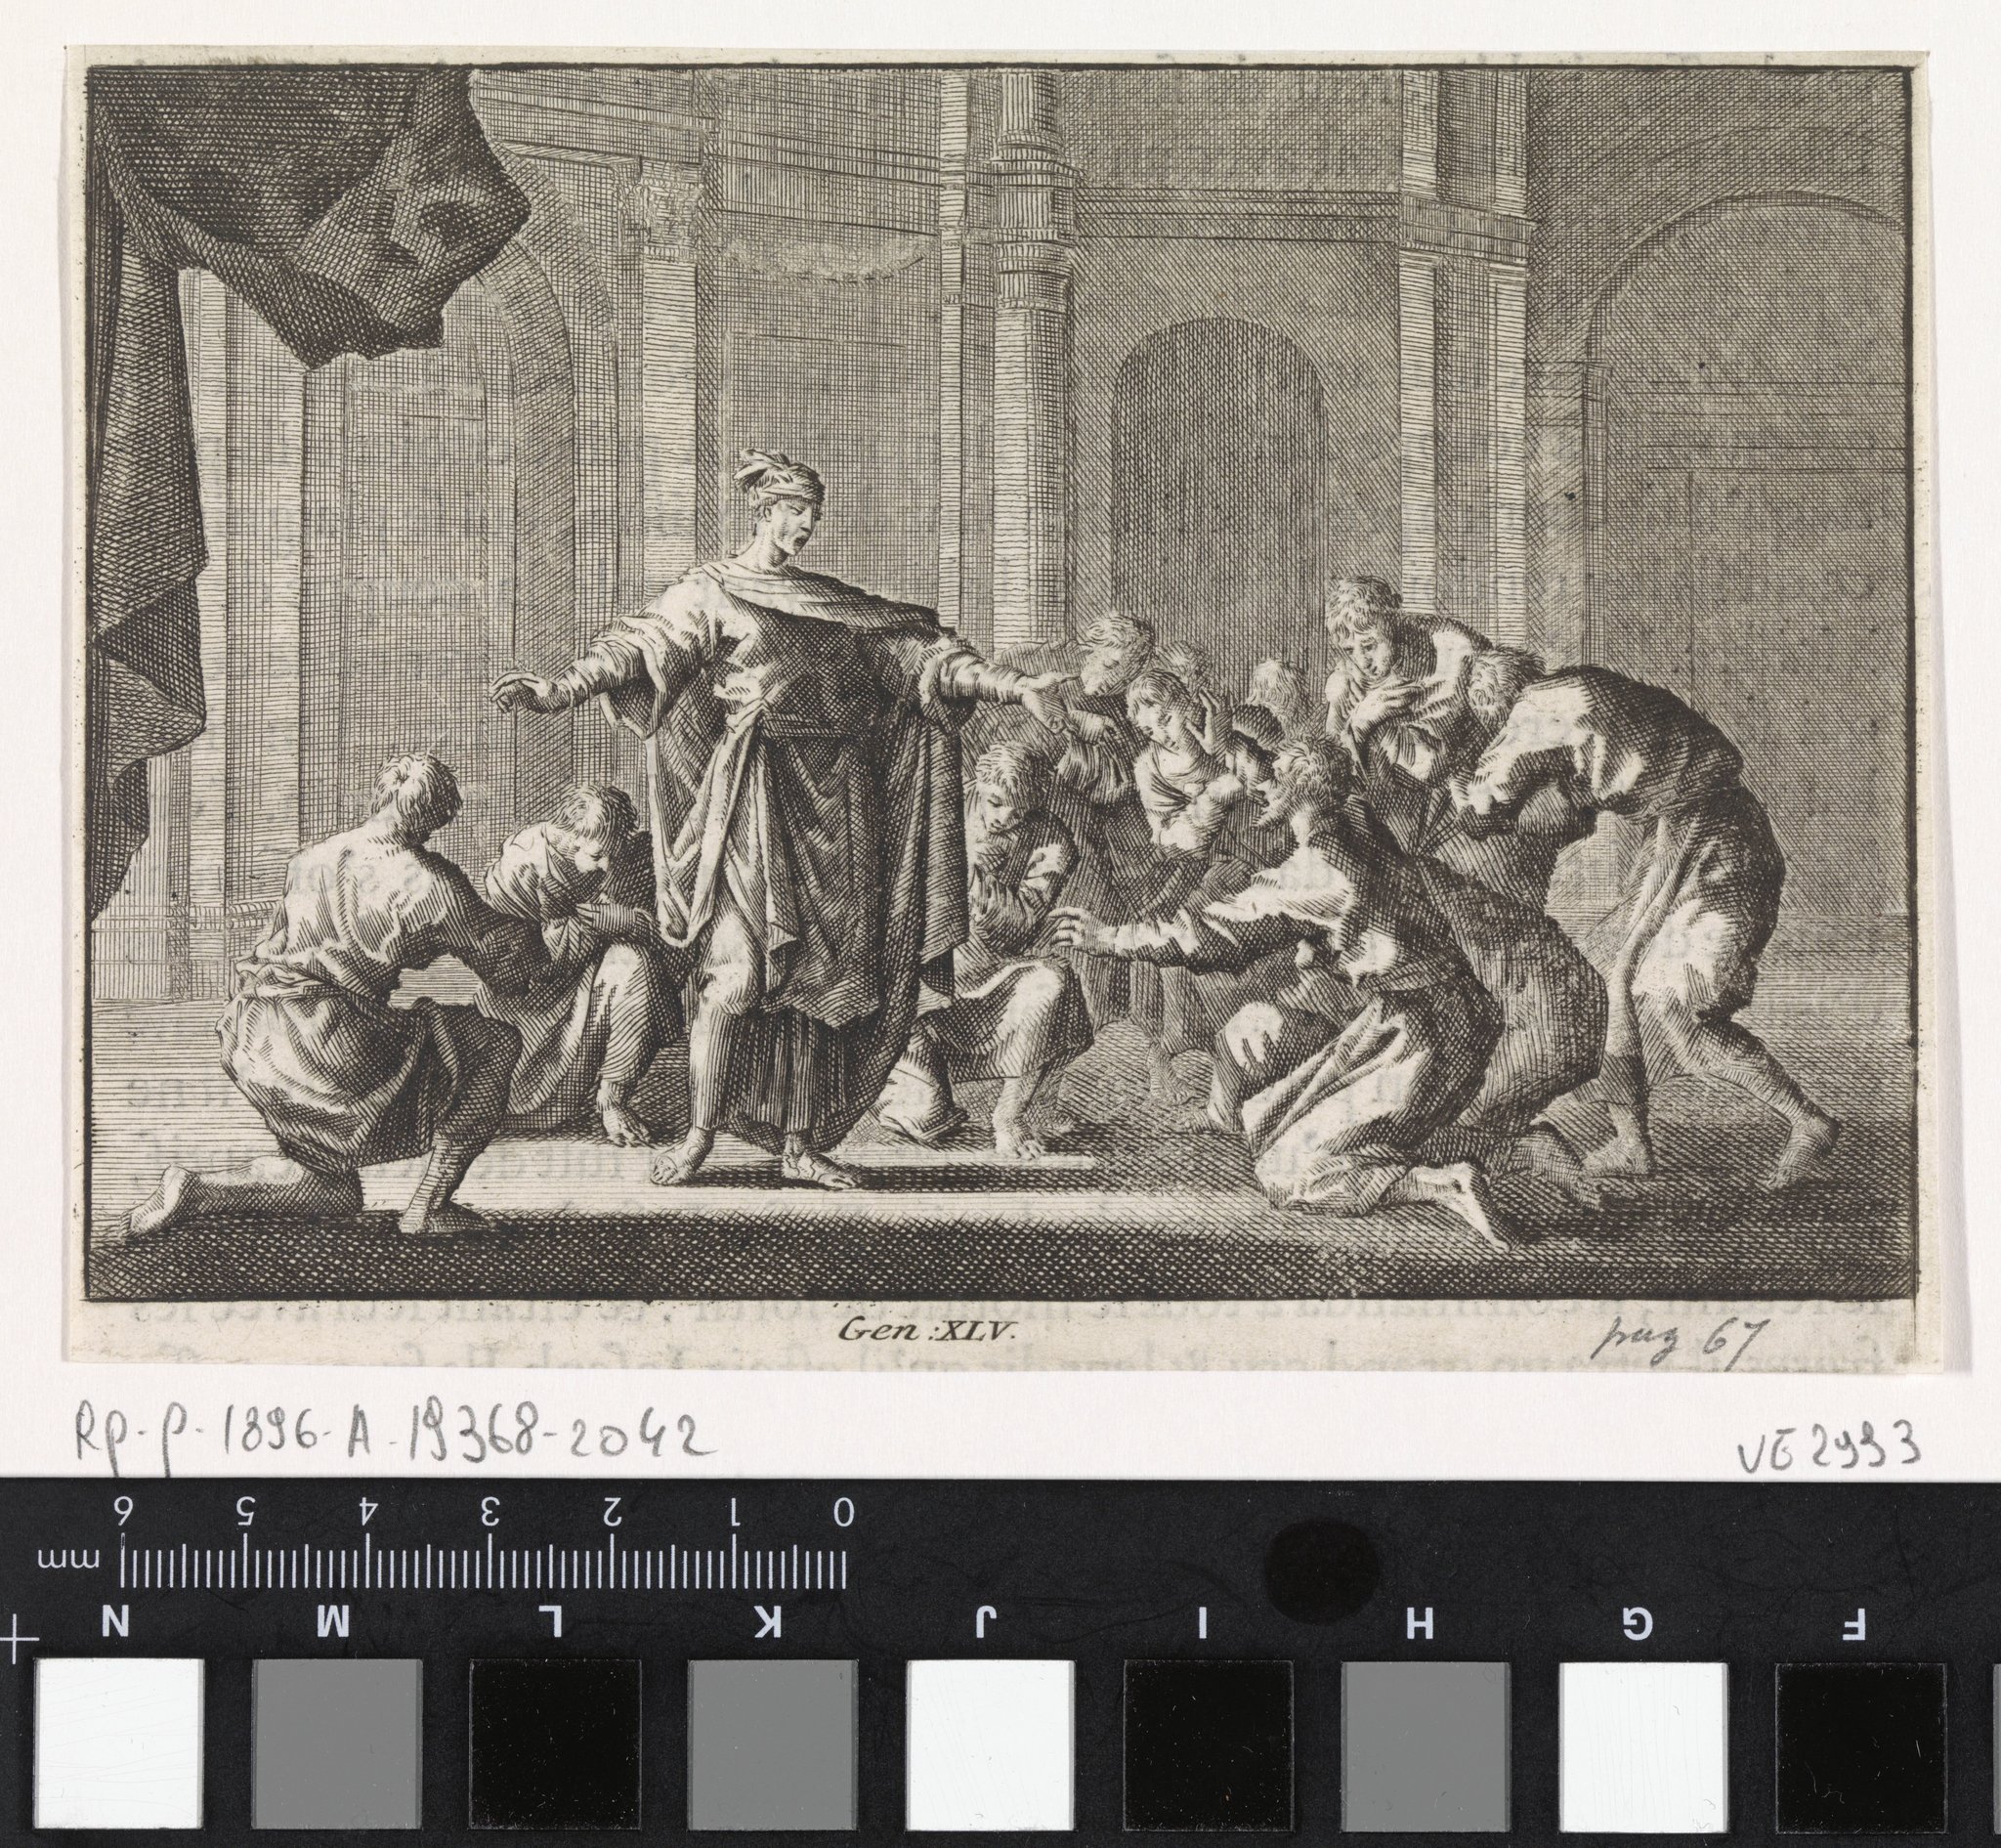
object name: book illustration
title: Jozef maakt zich bekend aan zijn broers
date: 1703-1762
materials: paper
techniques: etching, letterpress printing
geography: haarlem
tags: joseph reveals his identity and in tears forgives his brothers' past misdeed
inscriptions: collector's mark: Lugt 2228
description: De prent komt een eerste keer voor als boekillustratie voor David Martin. Historie des Ouden en Nieuwen Testaments. Amsterdam, Pieter Mortier, 1703. Deel I. De boekillustraties voor de Mortierbijbel hebben verschillende staten en kopieën, waarbij de chronologische volgorde moeilijk te achterhalen valt. Als boekillustraties werden ze bovendien herhaaldelijk opnieuw gebruikt voor andere boekwerken.